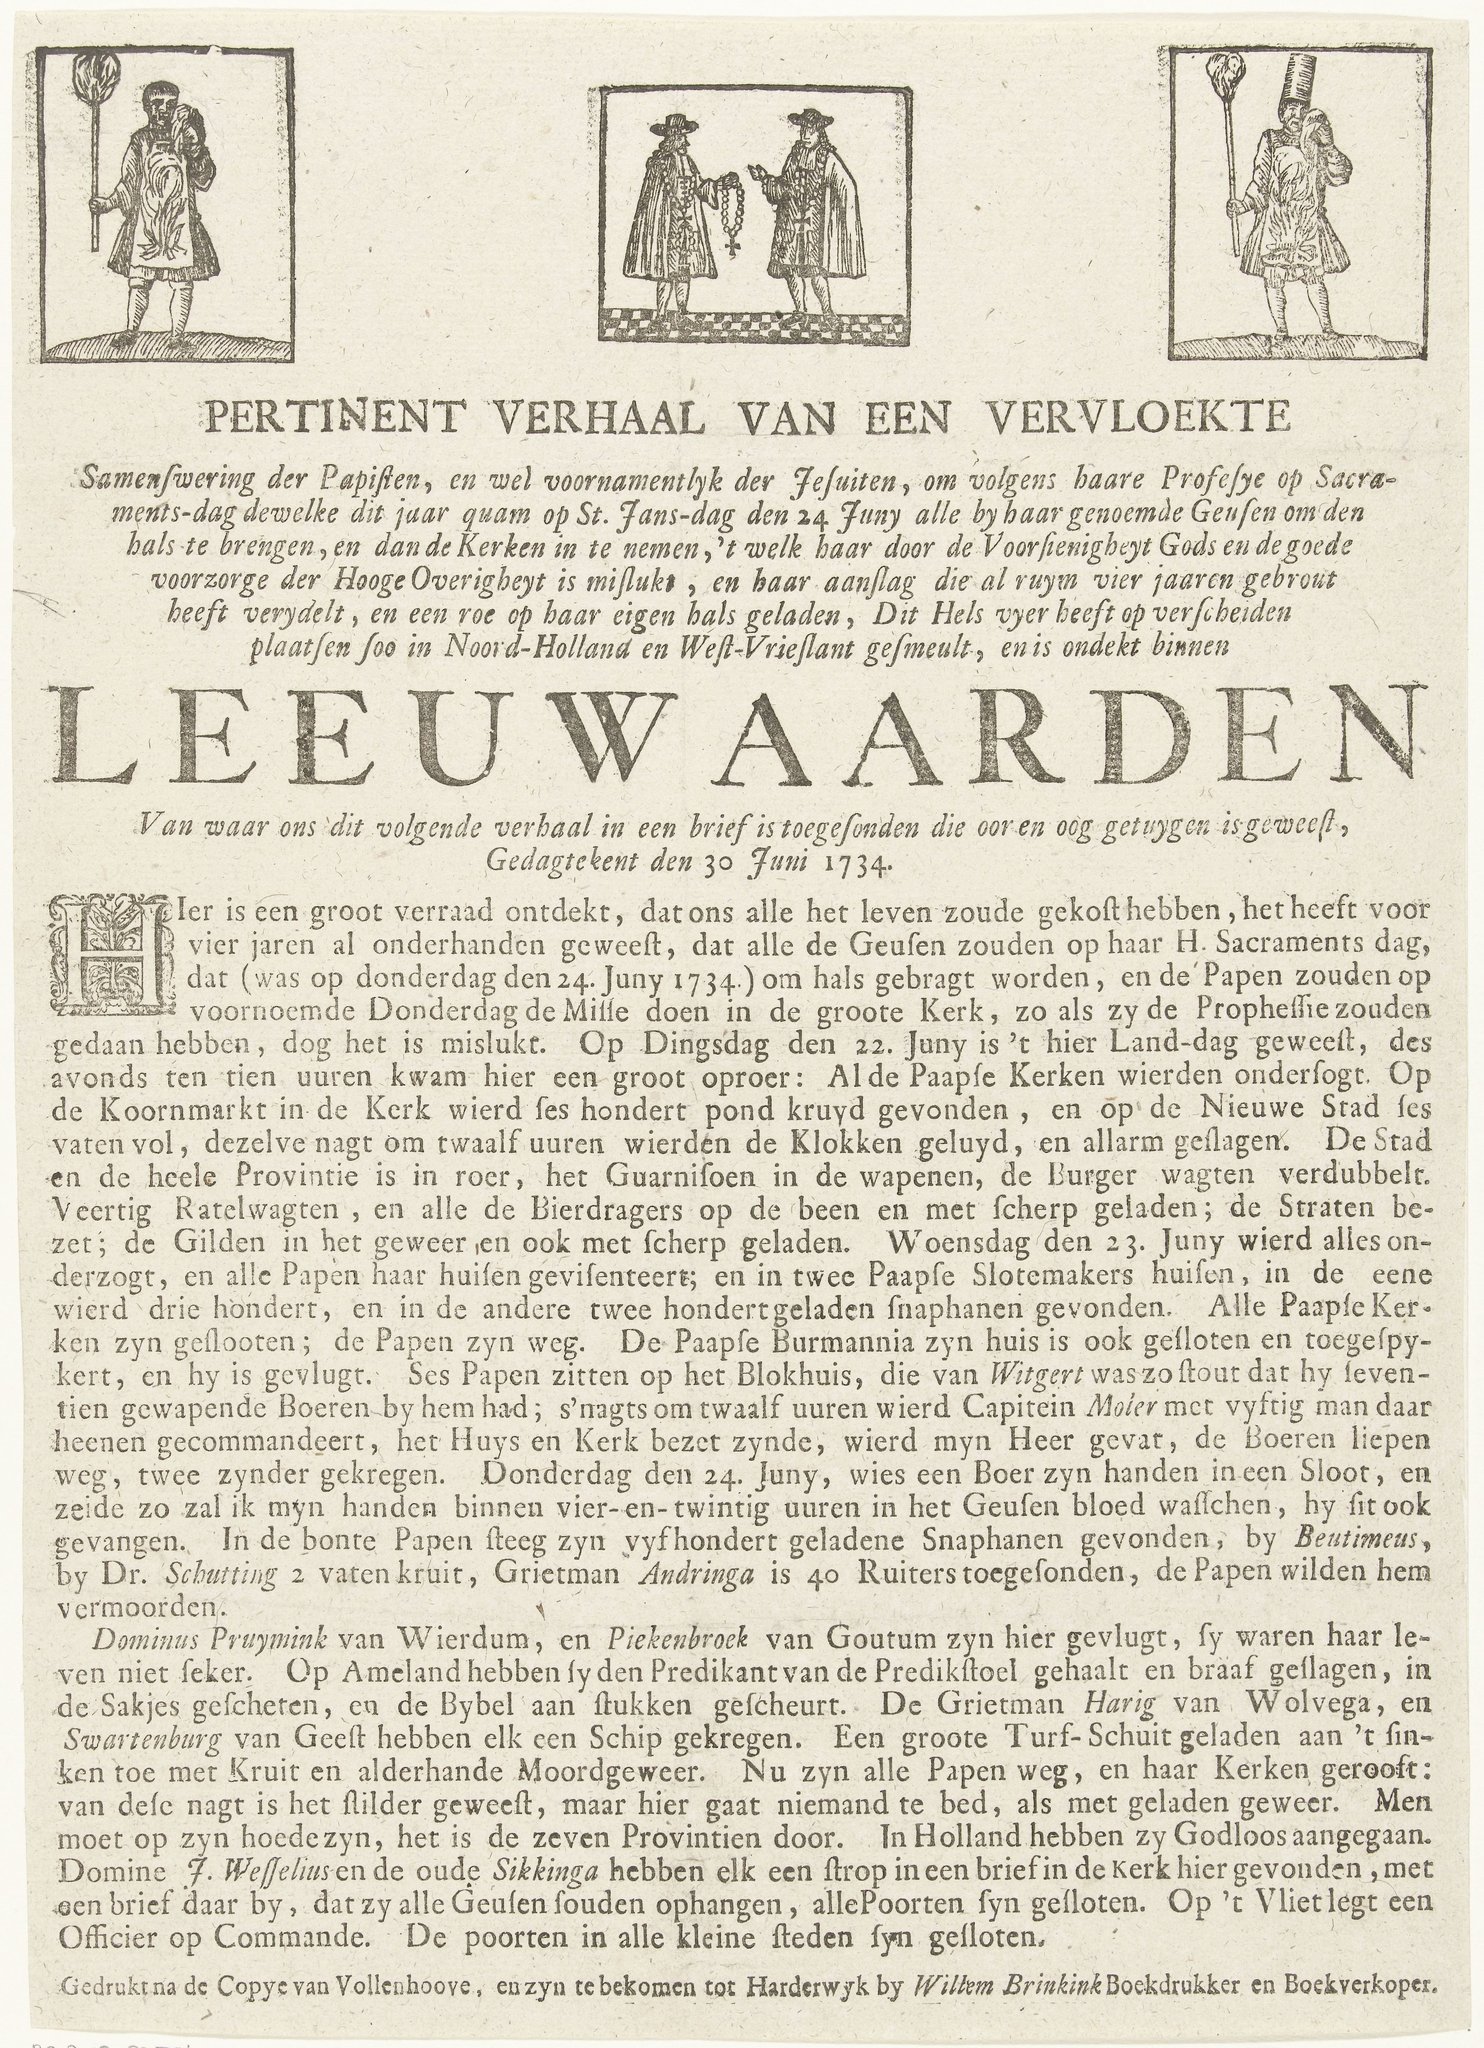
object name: print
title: Katholieke samenzwering te Leeuwarden, 1734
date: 1734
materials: paper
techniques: letterpress printing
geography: northern netherlands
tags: execution of heretic, e.g. by burning at the stake, 'auto-da-fé'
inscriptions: collector's mark: Lugt 2228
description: Verhaal van de ontdekking van een katholieke samenzwering te Leeuwarden om op Sacramentsdag 24 juni 1734 alle geuzen om te brengen en de kerken in te nemen. Tekst met een beschrijving van de gebeurtenissen, bovenaan enkele figuurtjes, waarvan twee van veroordeelden van de Spaanse Inquisitie bij een auto-da-fe. De brief gedateerd 30 juni 1734.